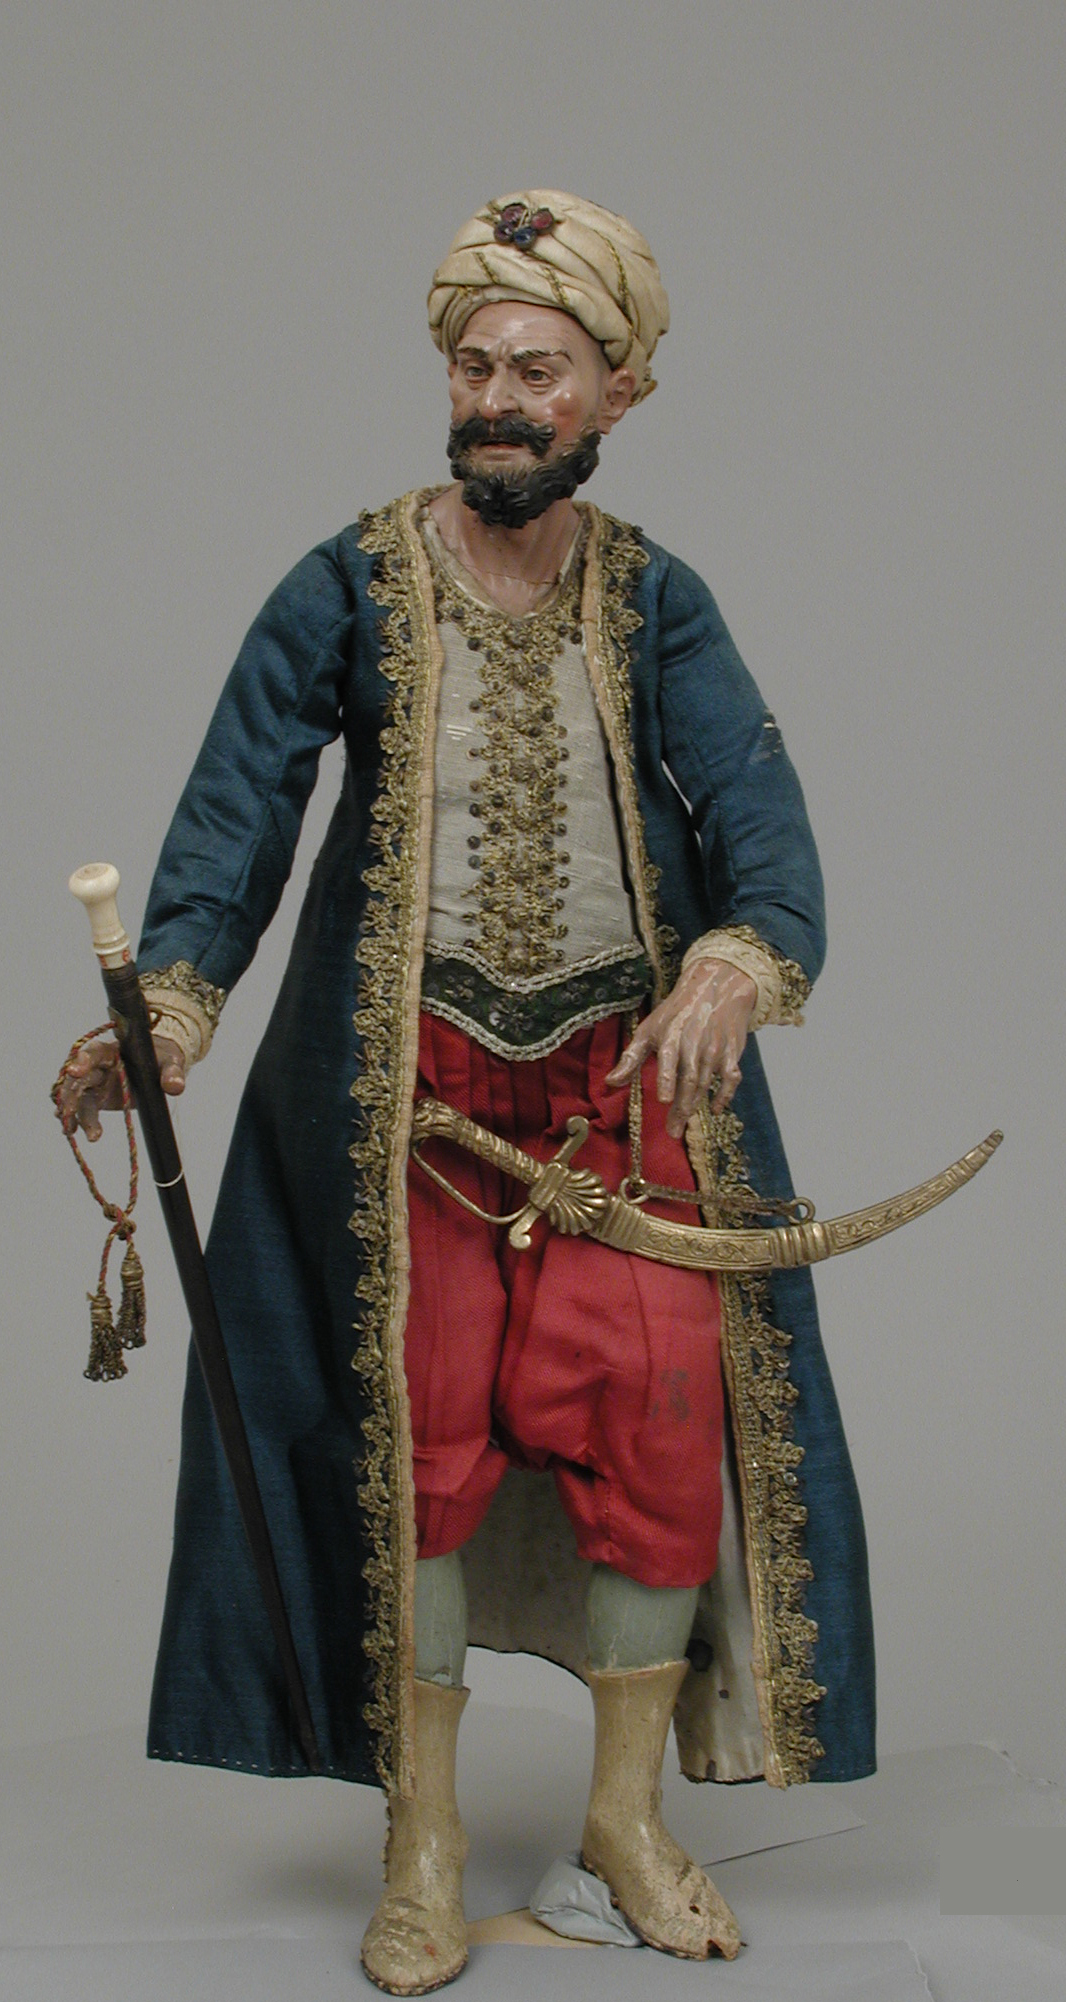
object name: crèche figure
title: King's attendant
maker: giuseppe gori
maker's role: maker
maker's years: 1770-1810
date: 1751-1800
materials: brass, cotton, glass, gold, ivory, leather, metal thread, textile, silver, stone, terracotta, fiber, velvet, metal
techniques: backing, polychrome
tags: swords,men